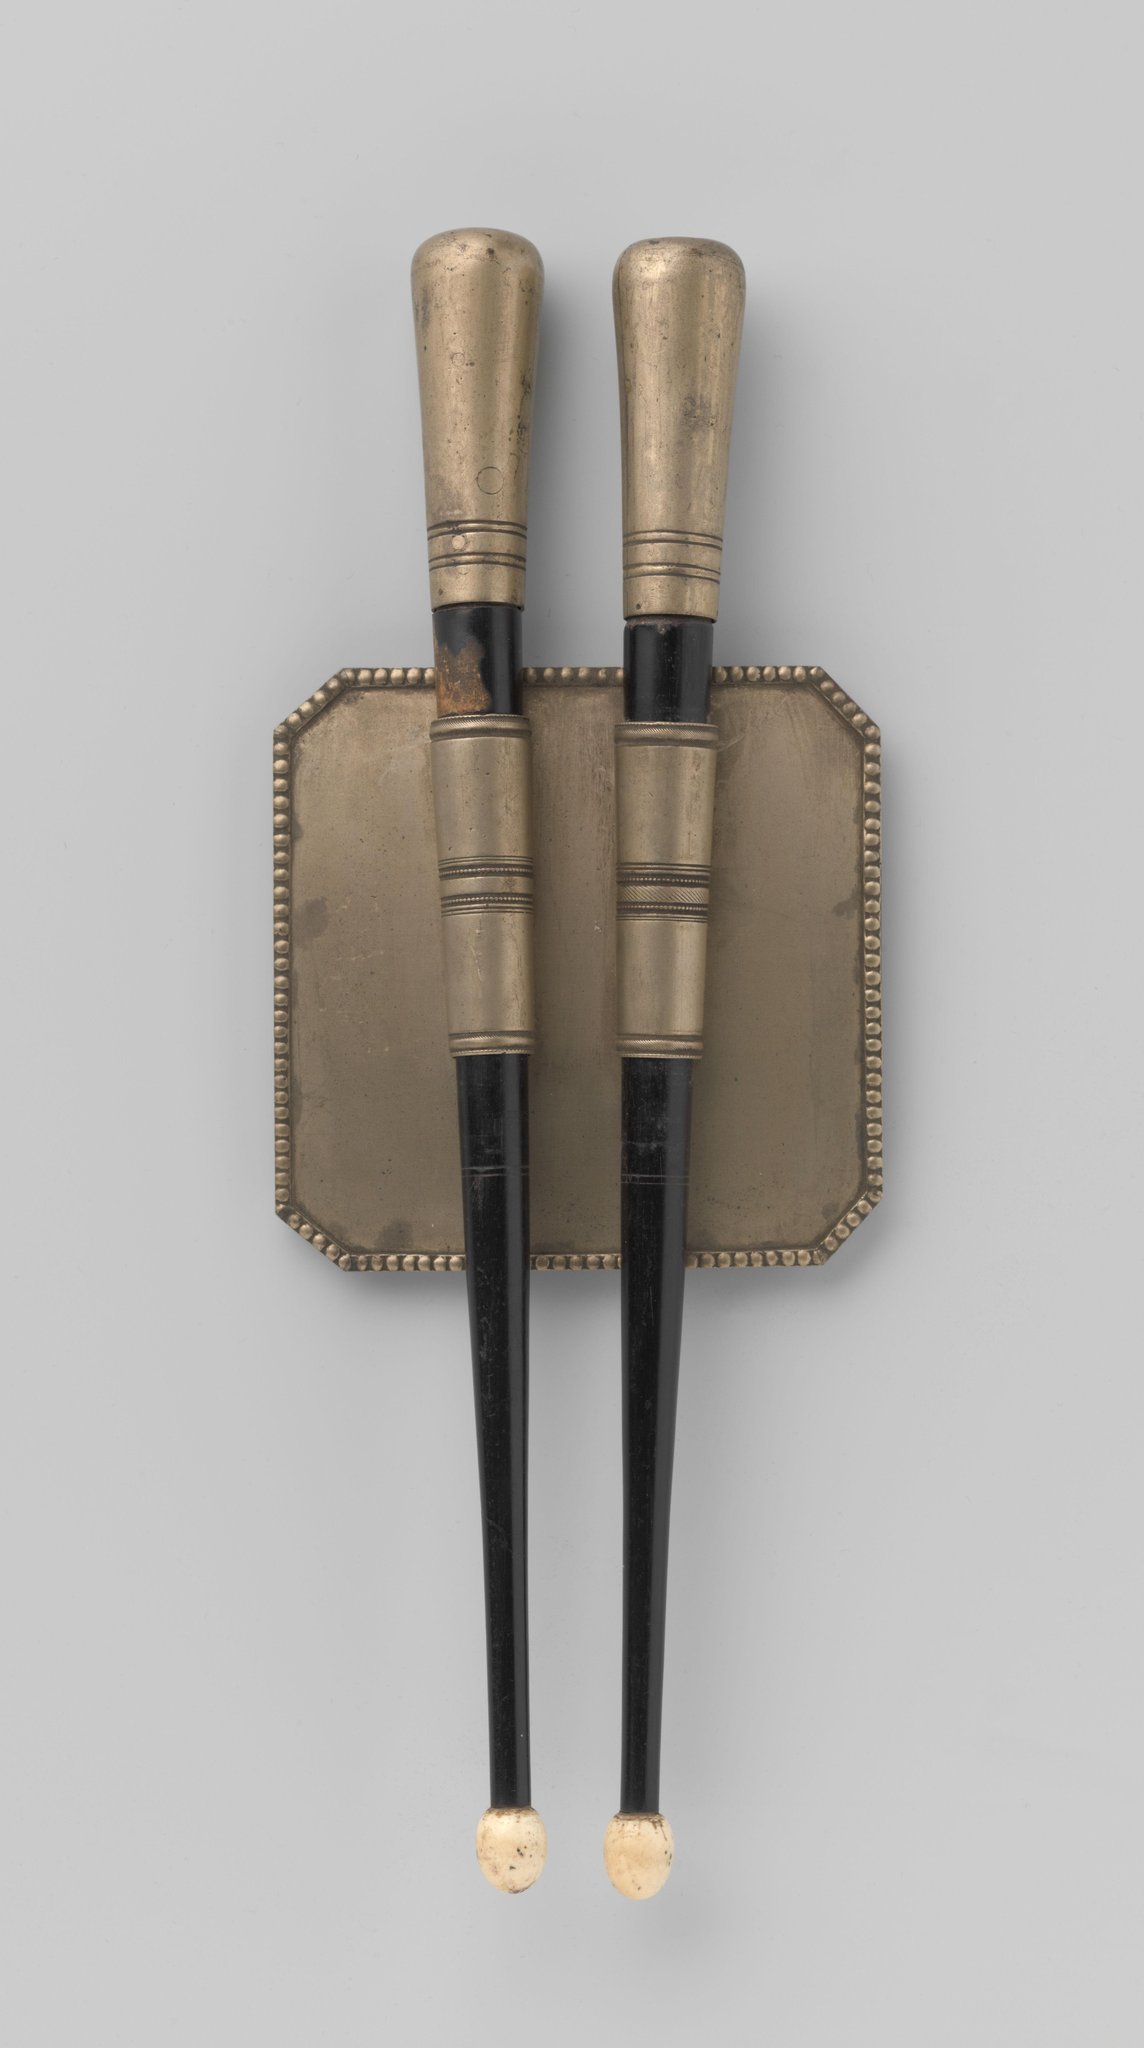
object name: beater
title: Drumsticks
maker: Anonymous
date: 1817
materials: wood, ivory, plate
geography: netherlands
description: Ebbenhouten tromstok voor tamboer-majoor met ivoren knop. Stok bezet met bussen van pleet.